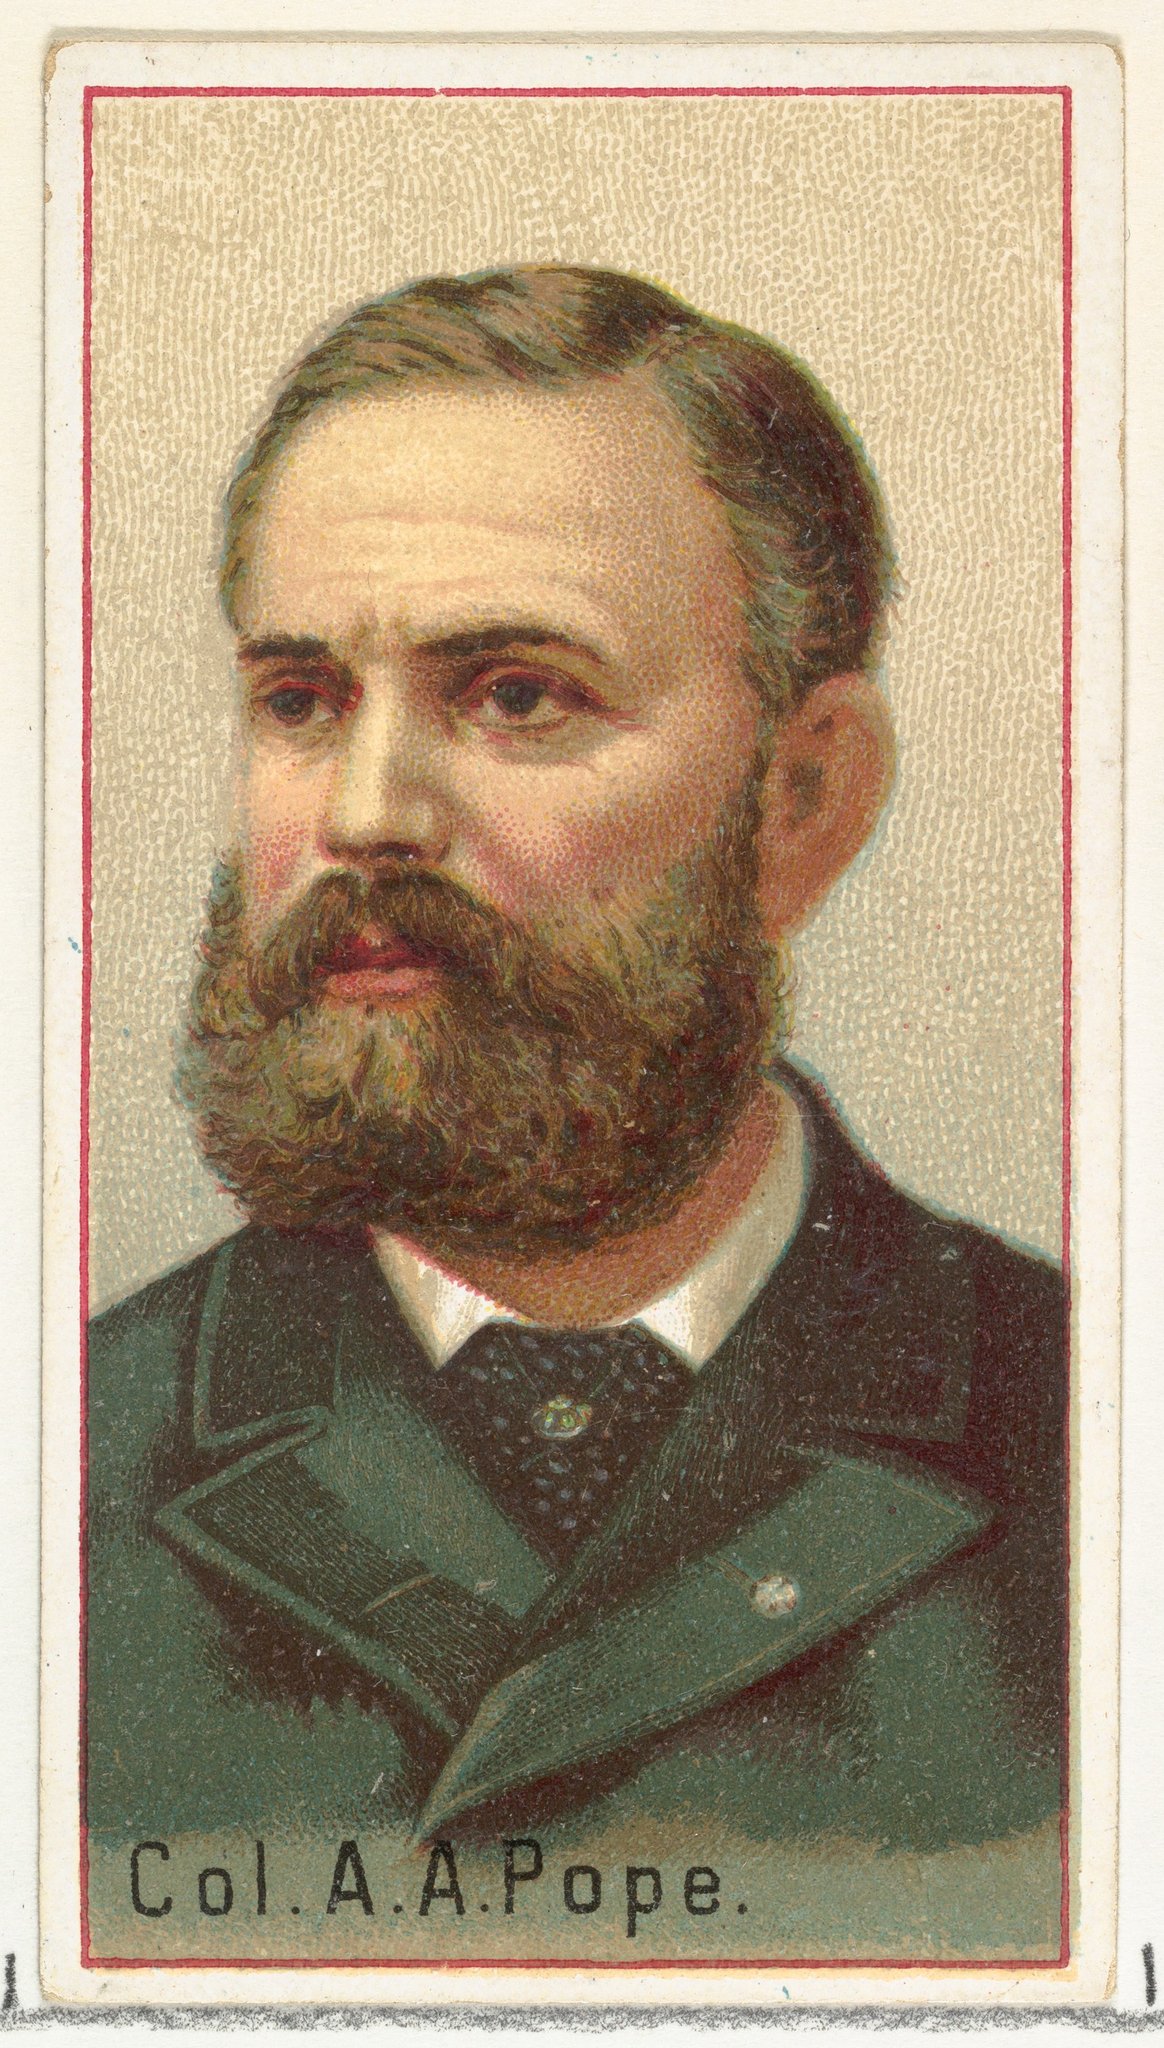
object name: print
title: Colonel A. A. Pope, printer's sample for the World's Inventors souvenir album (A25) for Allen & Ginter Cigarettes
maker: allen & ginter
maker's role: publisher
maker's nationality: american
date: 1888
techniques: color lithograph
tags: men,portraits